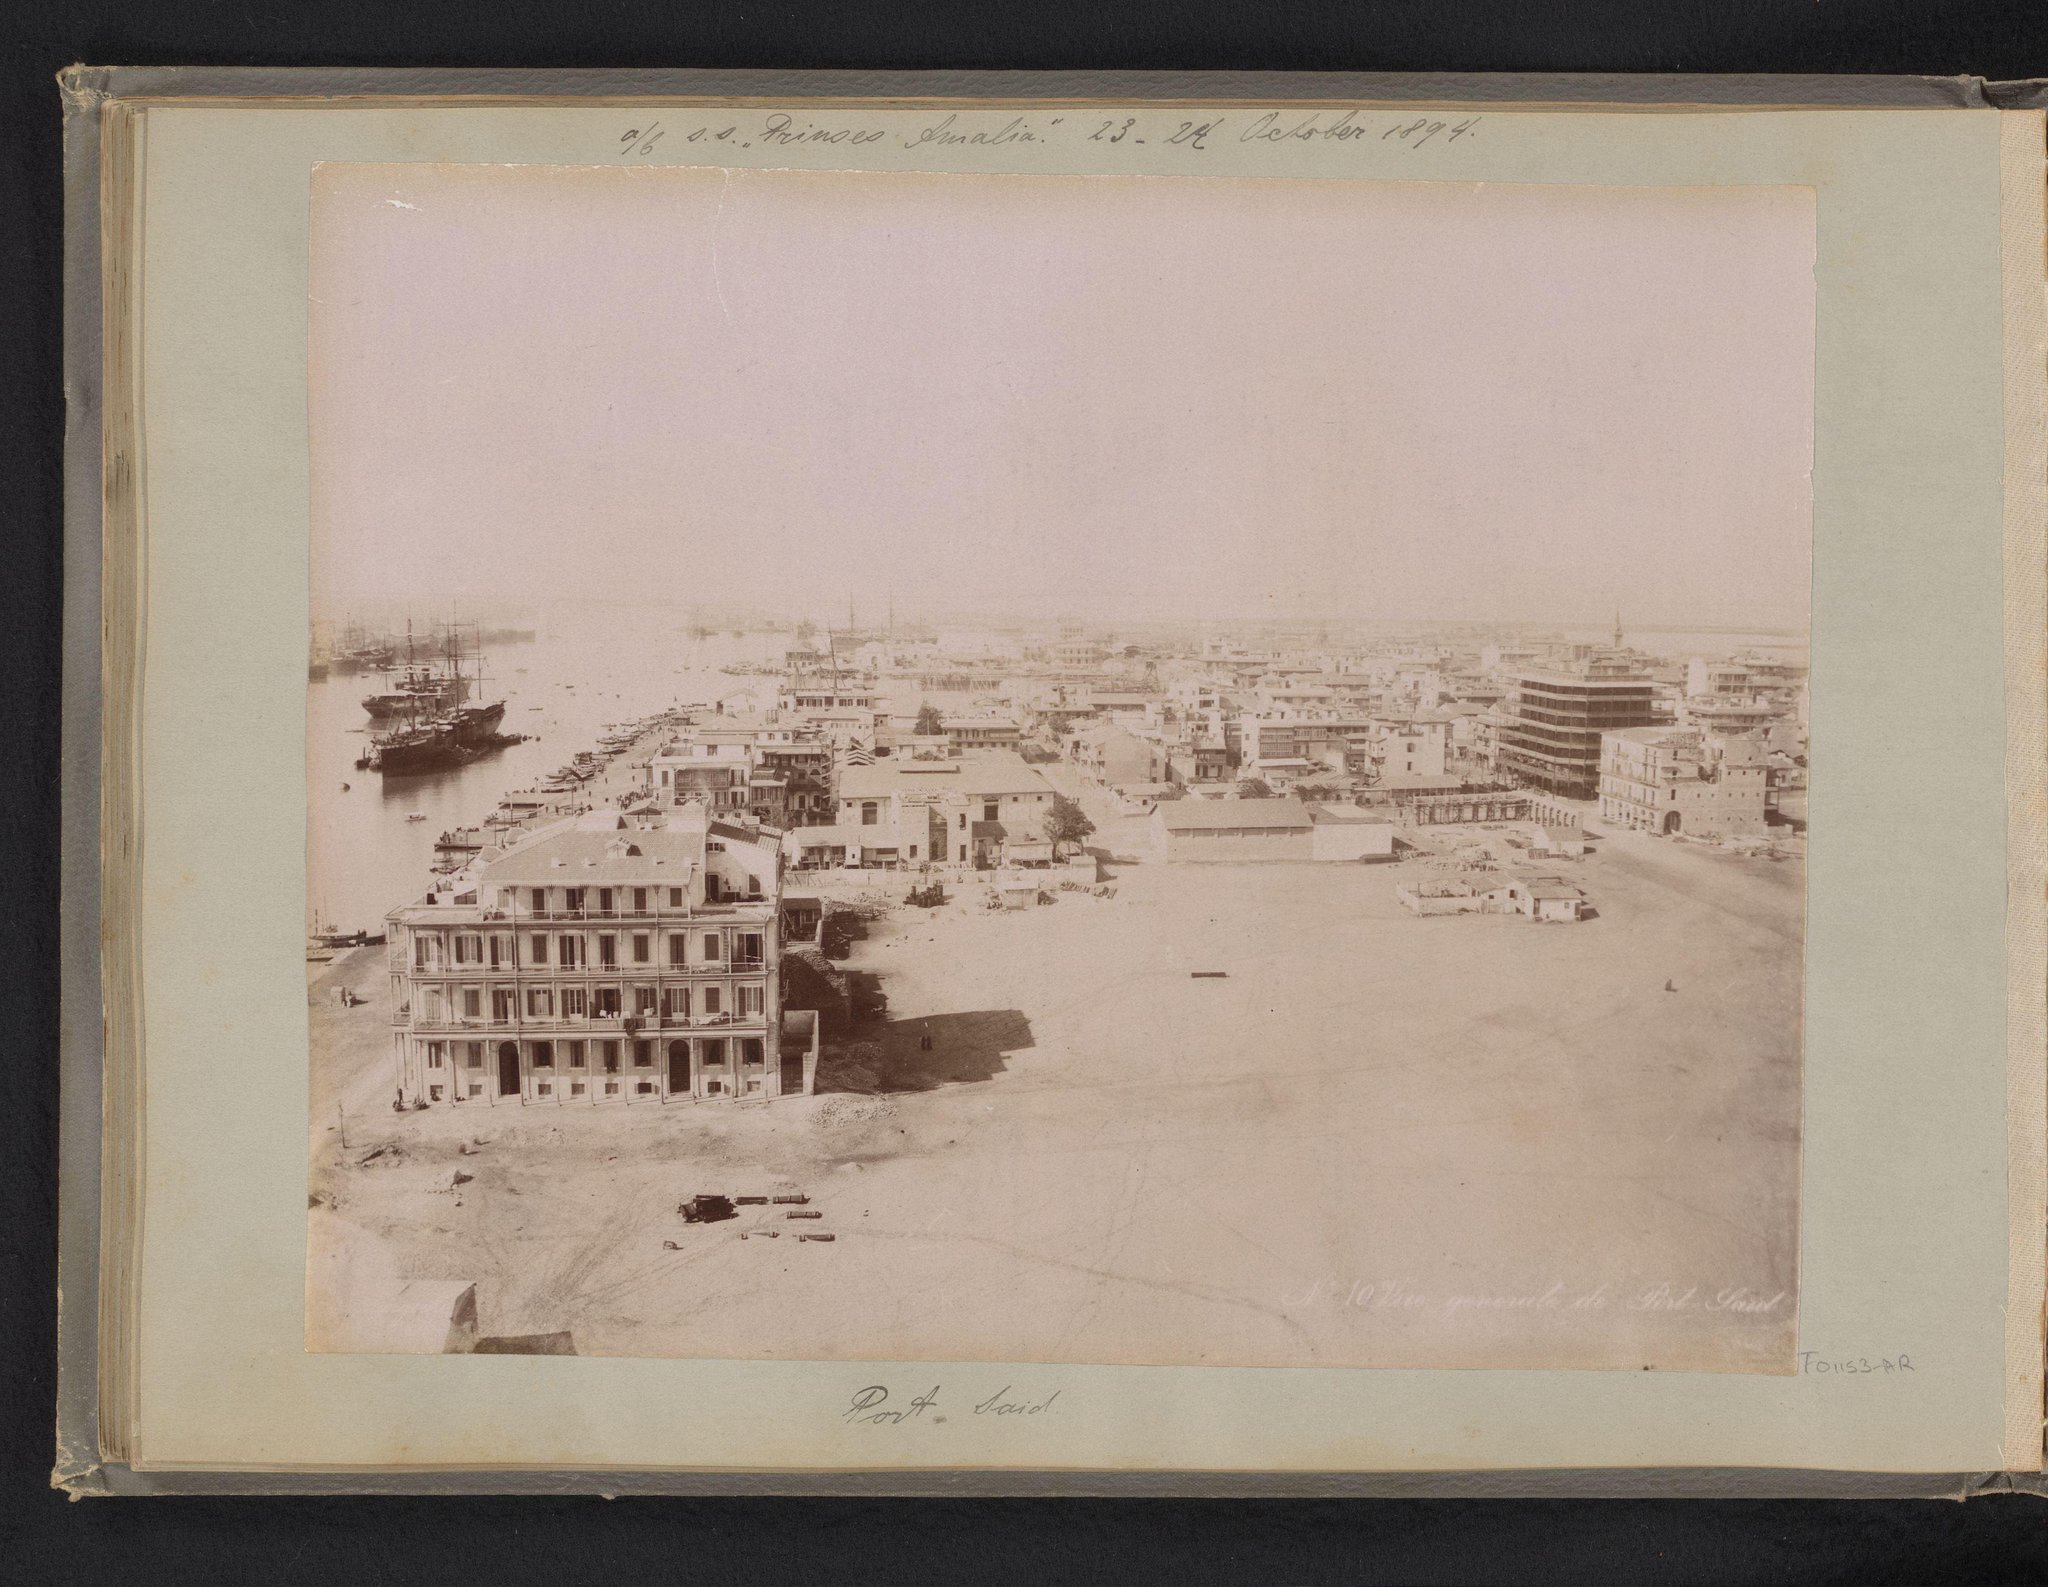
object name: photograph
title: Gezicht op Port Said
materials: photographic support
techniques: albumen print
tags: city-view in general; 'veduta'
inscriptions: inscription: ‘No. 10 Vue generale de Port-Said’, annotation: ‘a/b s.s. Prinses Amalia." 23-27 October 1894’